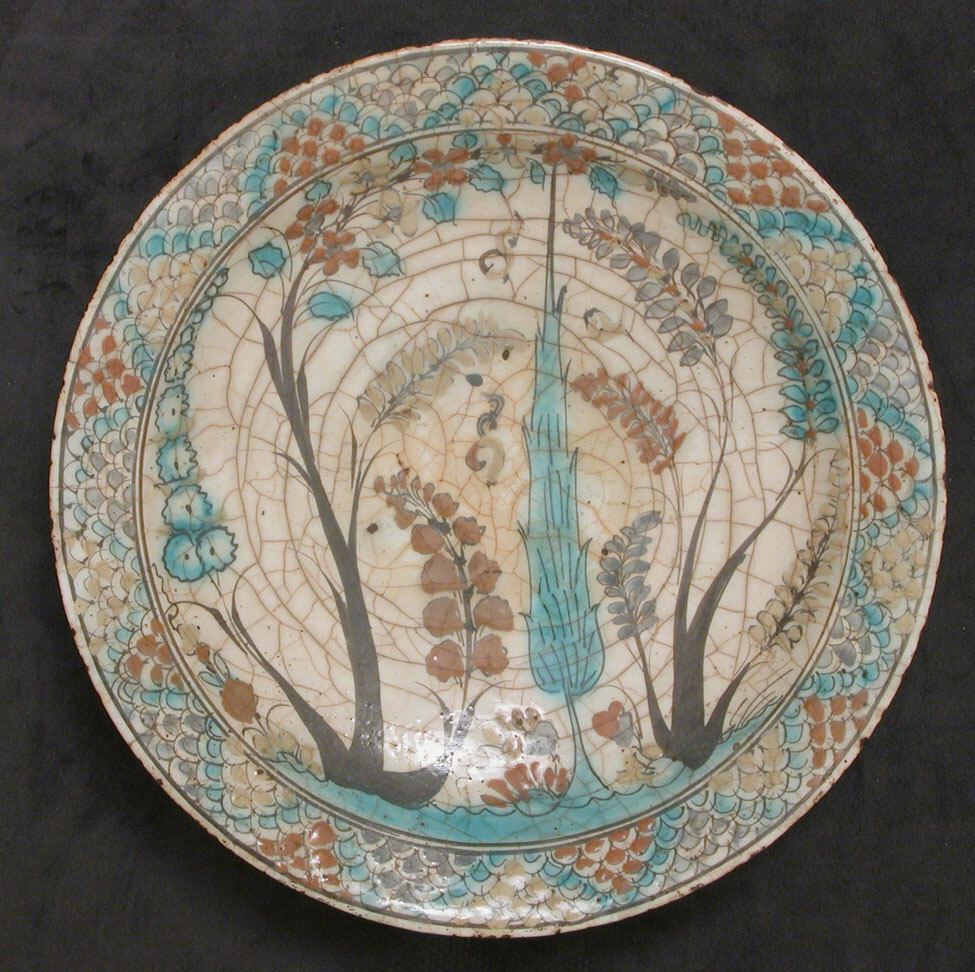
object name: dish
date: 1601-1700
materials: stonepaste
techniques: painting, underglaze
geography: iran